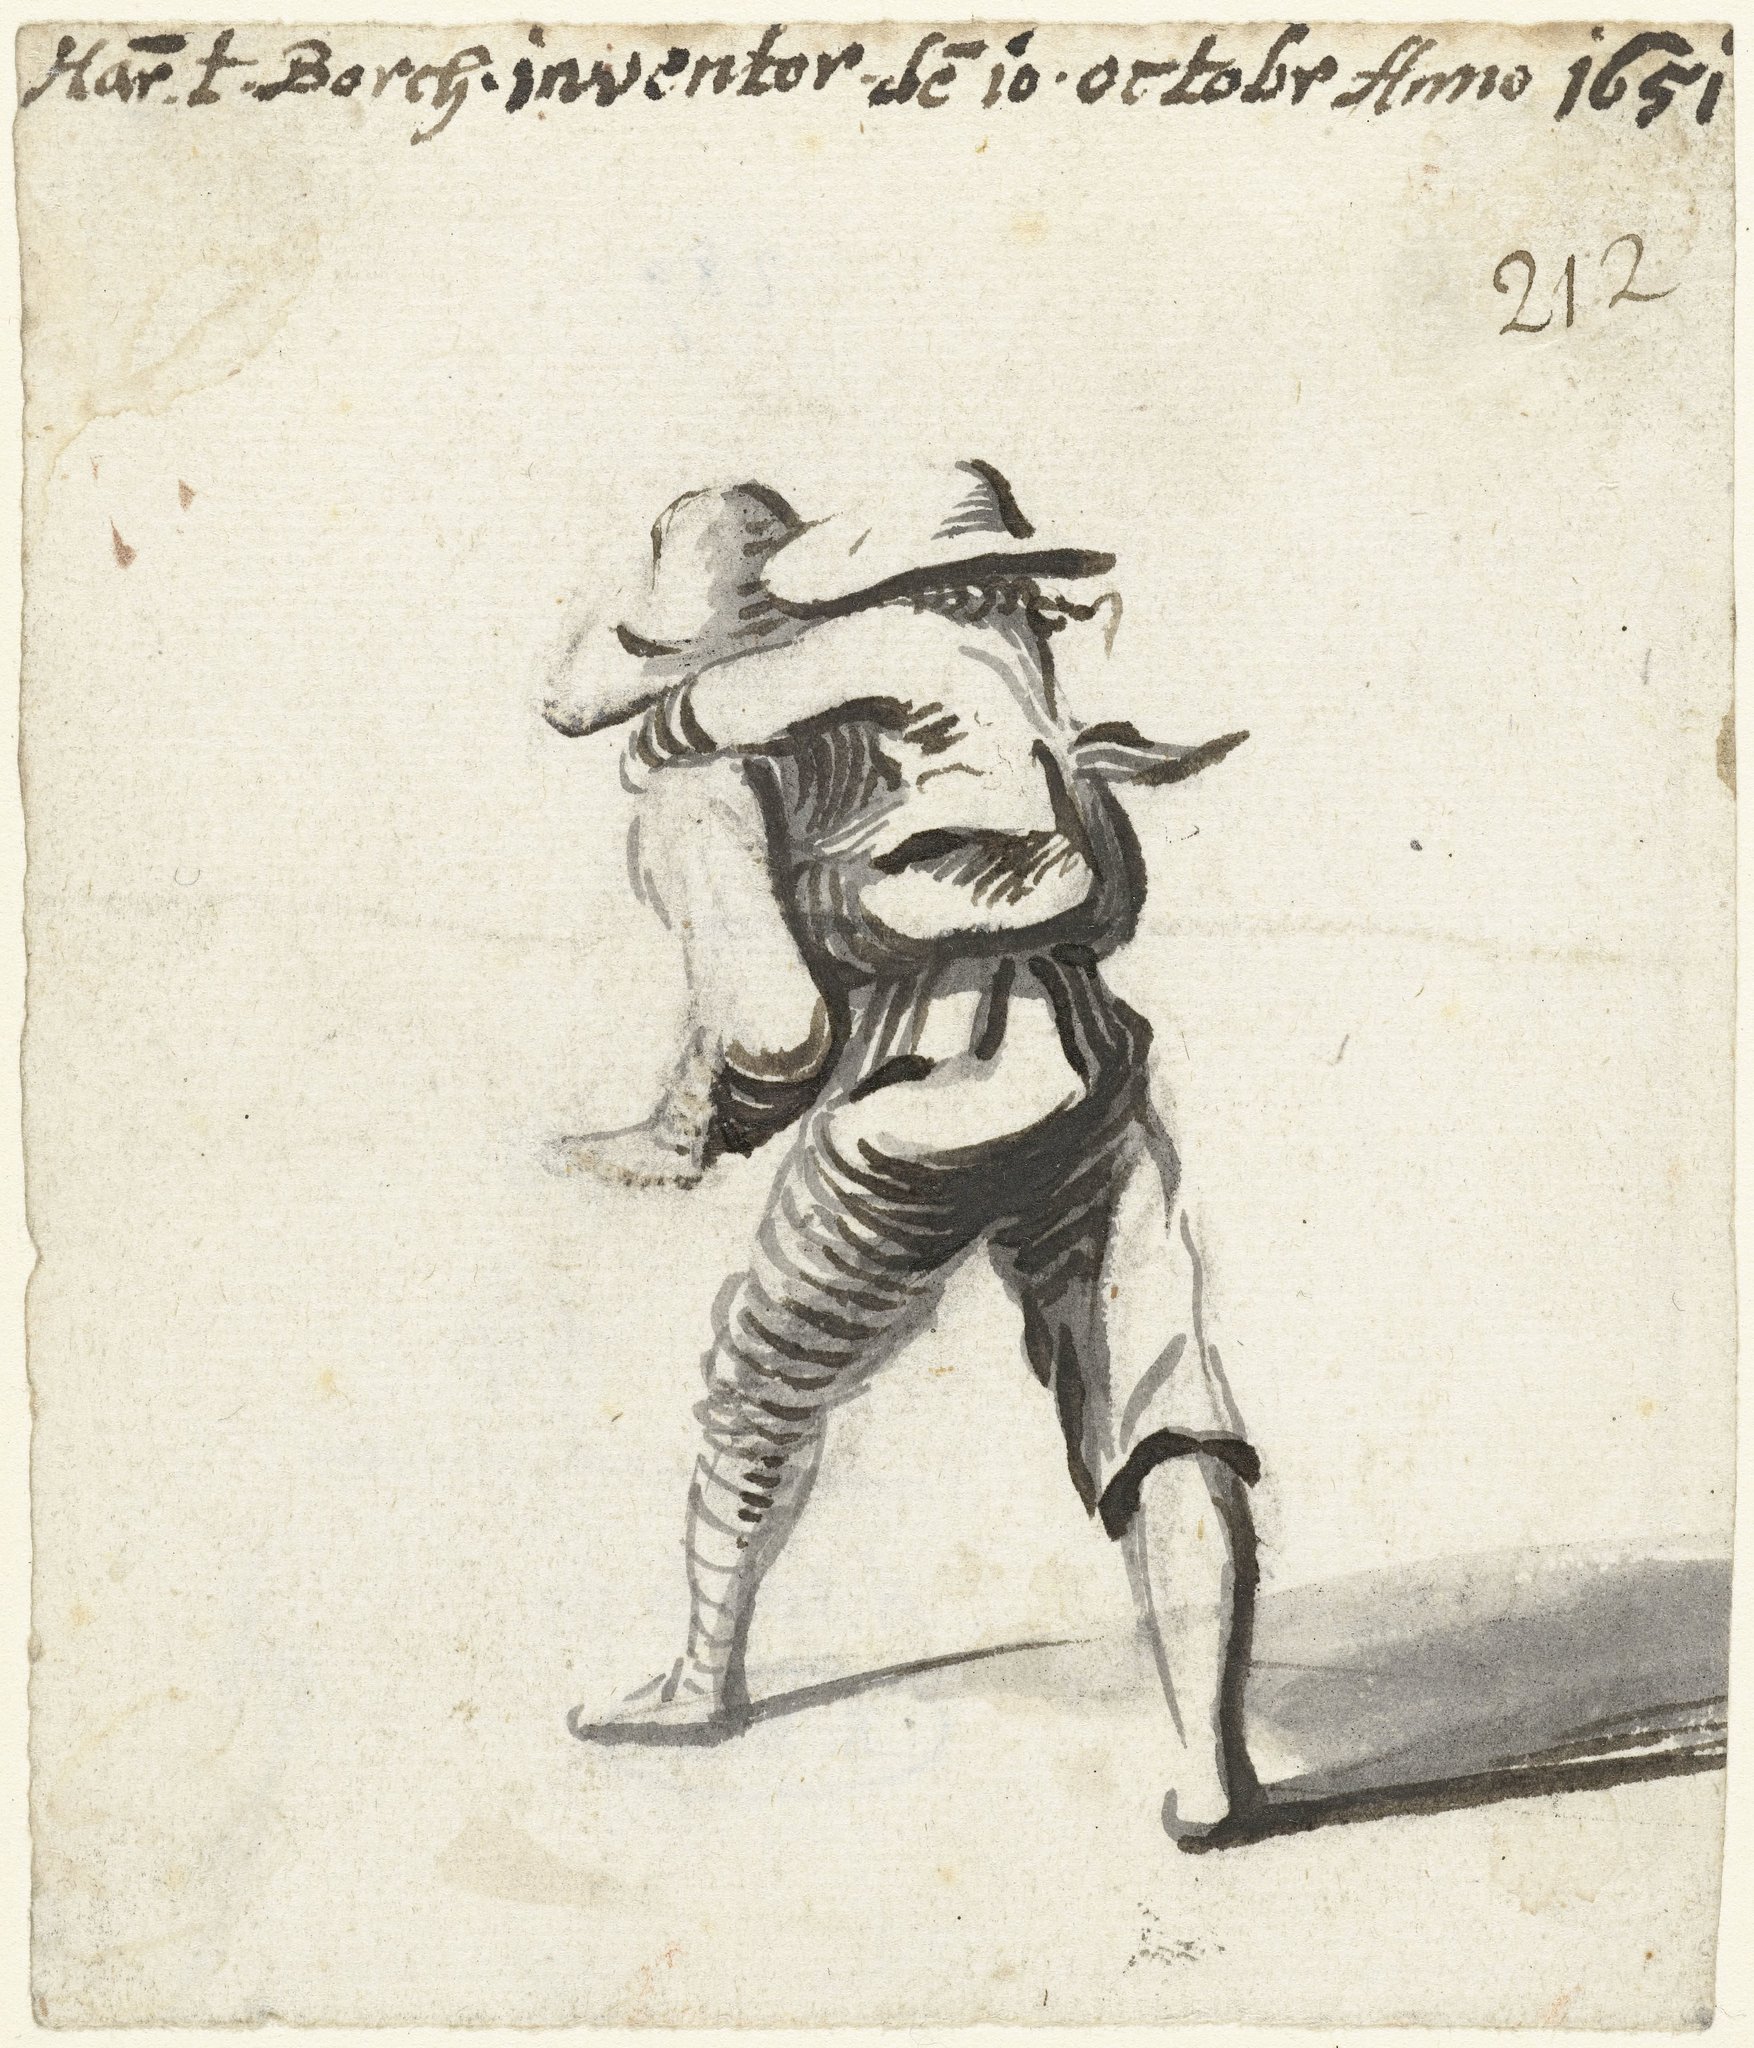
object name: drawing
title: Jongen draagt een andere jongen op de rug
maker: harmen ter borch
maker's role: draughtsman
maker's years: 1638-1677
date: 1651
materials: chalk, ink, paper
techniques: brush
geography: zwolle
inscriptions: annotation: ‘Har[man].t.Borch. inventor. de[n] 10.octobr Anno 1651’